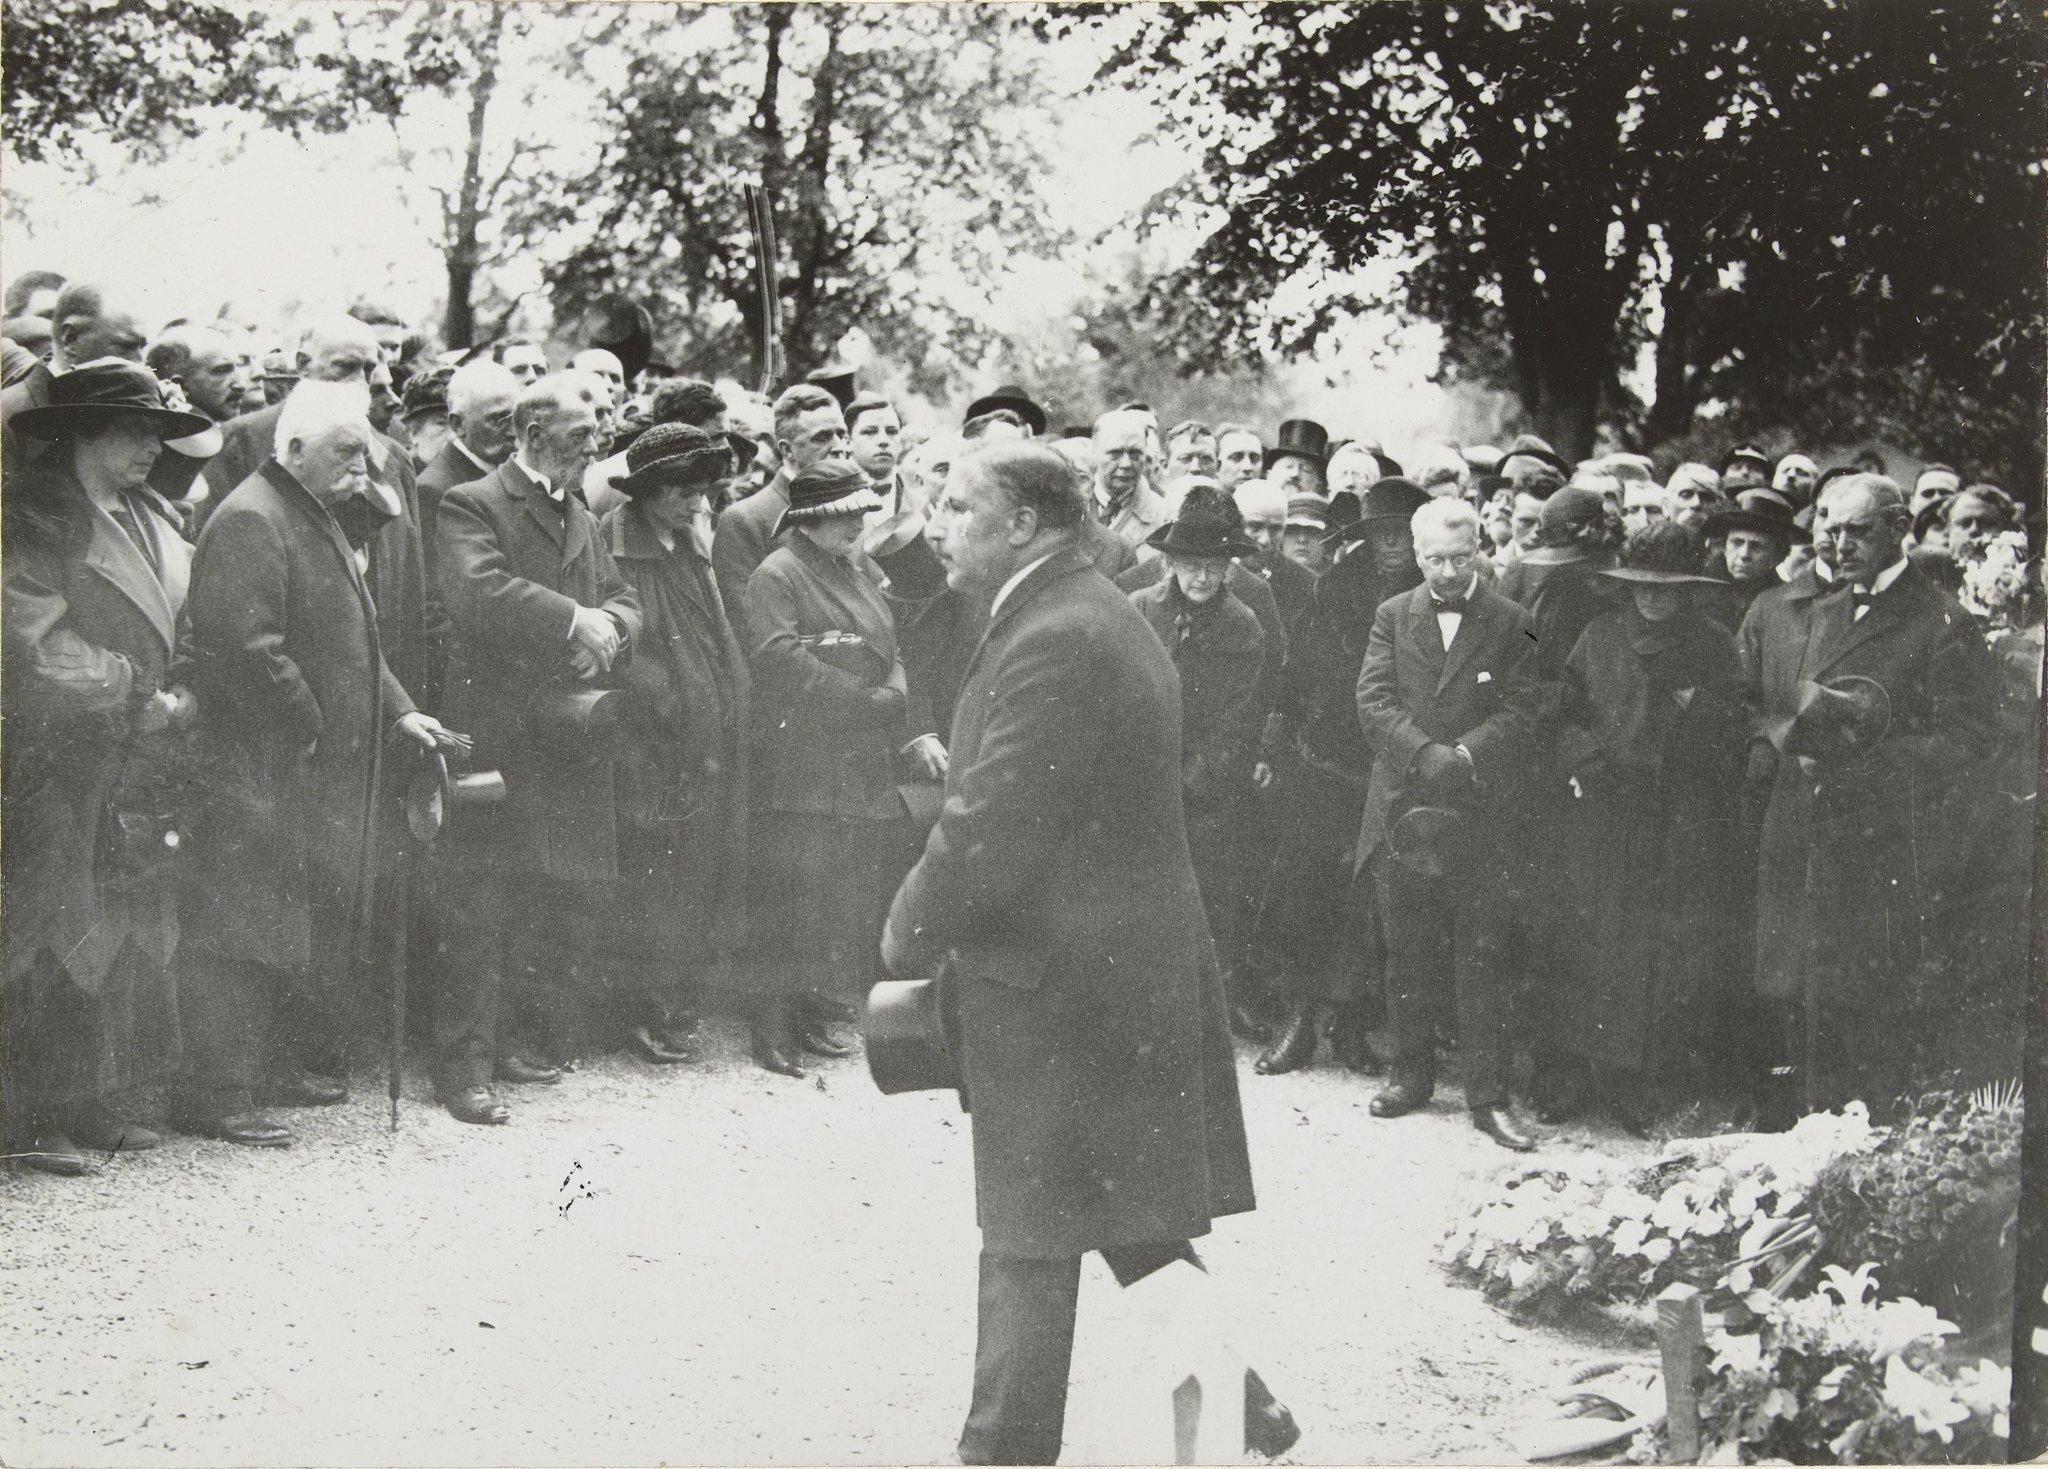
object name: photograph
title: Begrafenis, mogelijk van Breitner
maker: Anonymous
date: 1923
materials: cardboard, photographic support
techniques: gelatin silver print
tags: rotterdam, amsterdam, painter, print maker, draughtsman, george hendrik breitner, burial